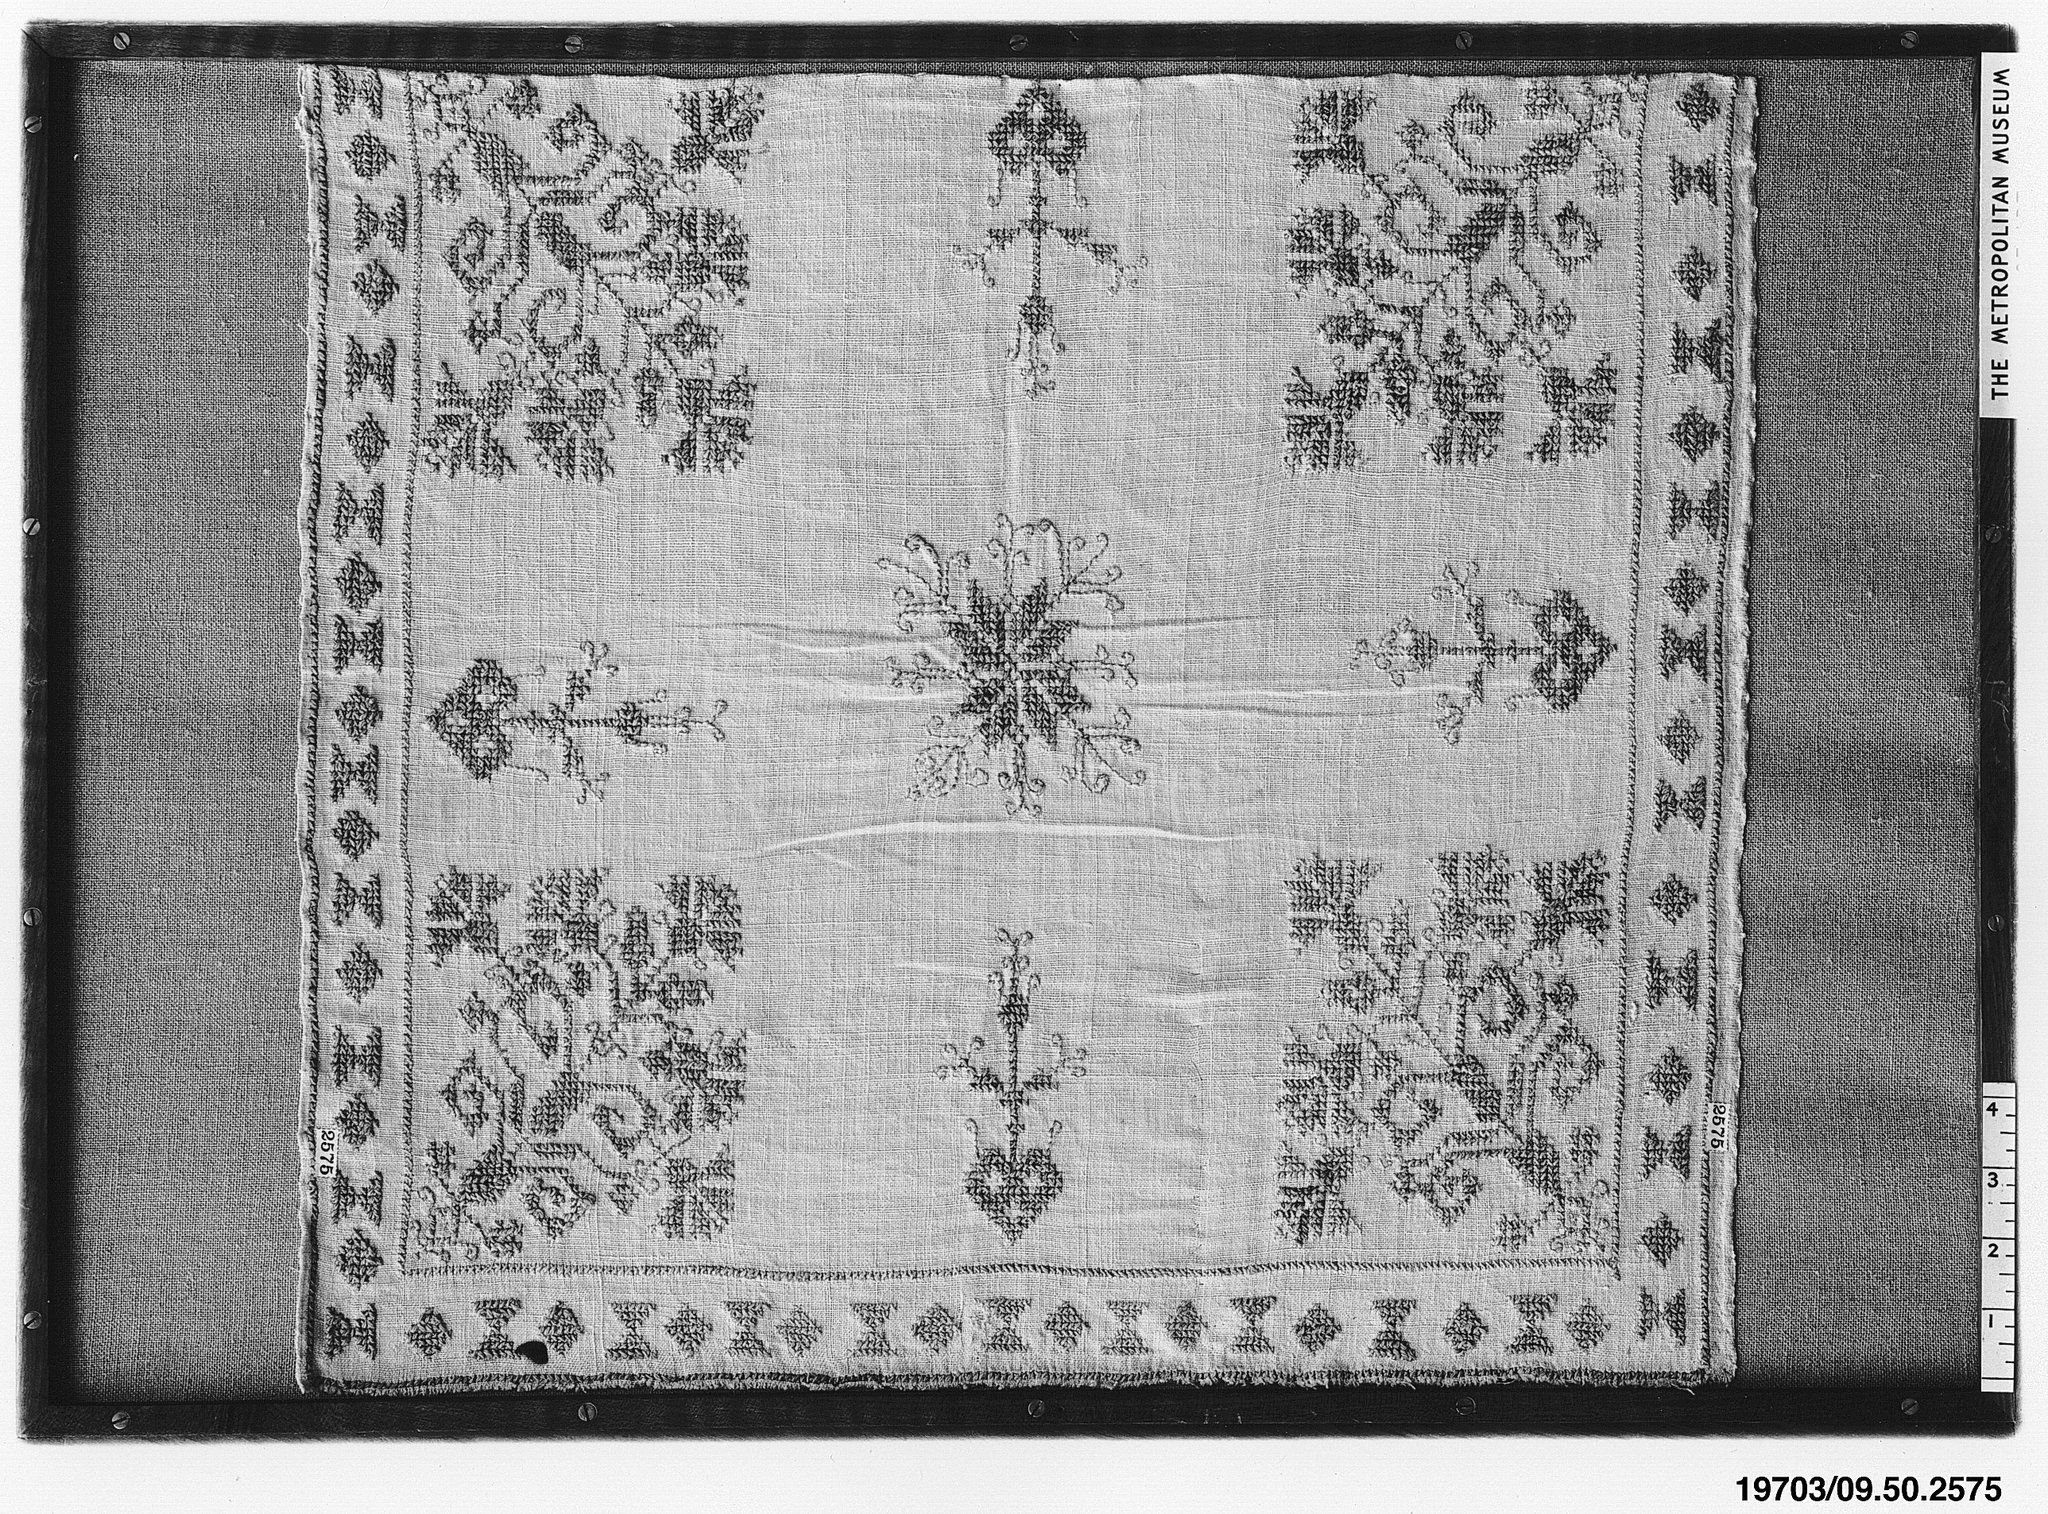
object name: square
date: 1701-1800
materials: linen